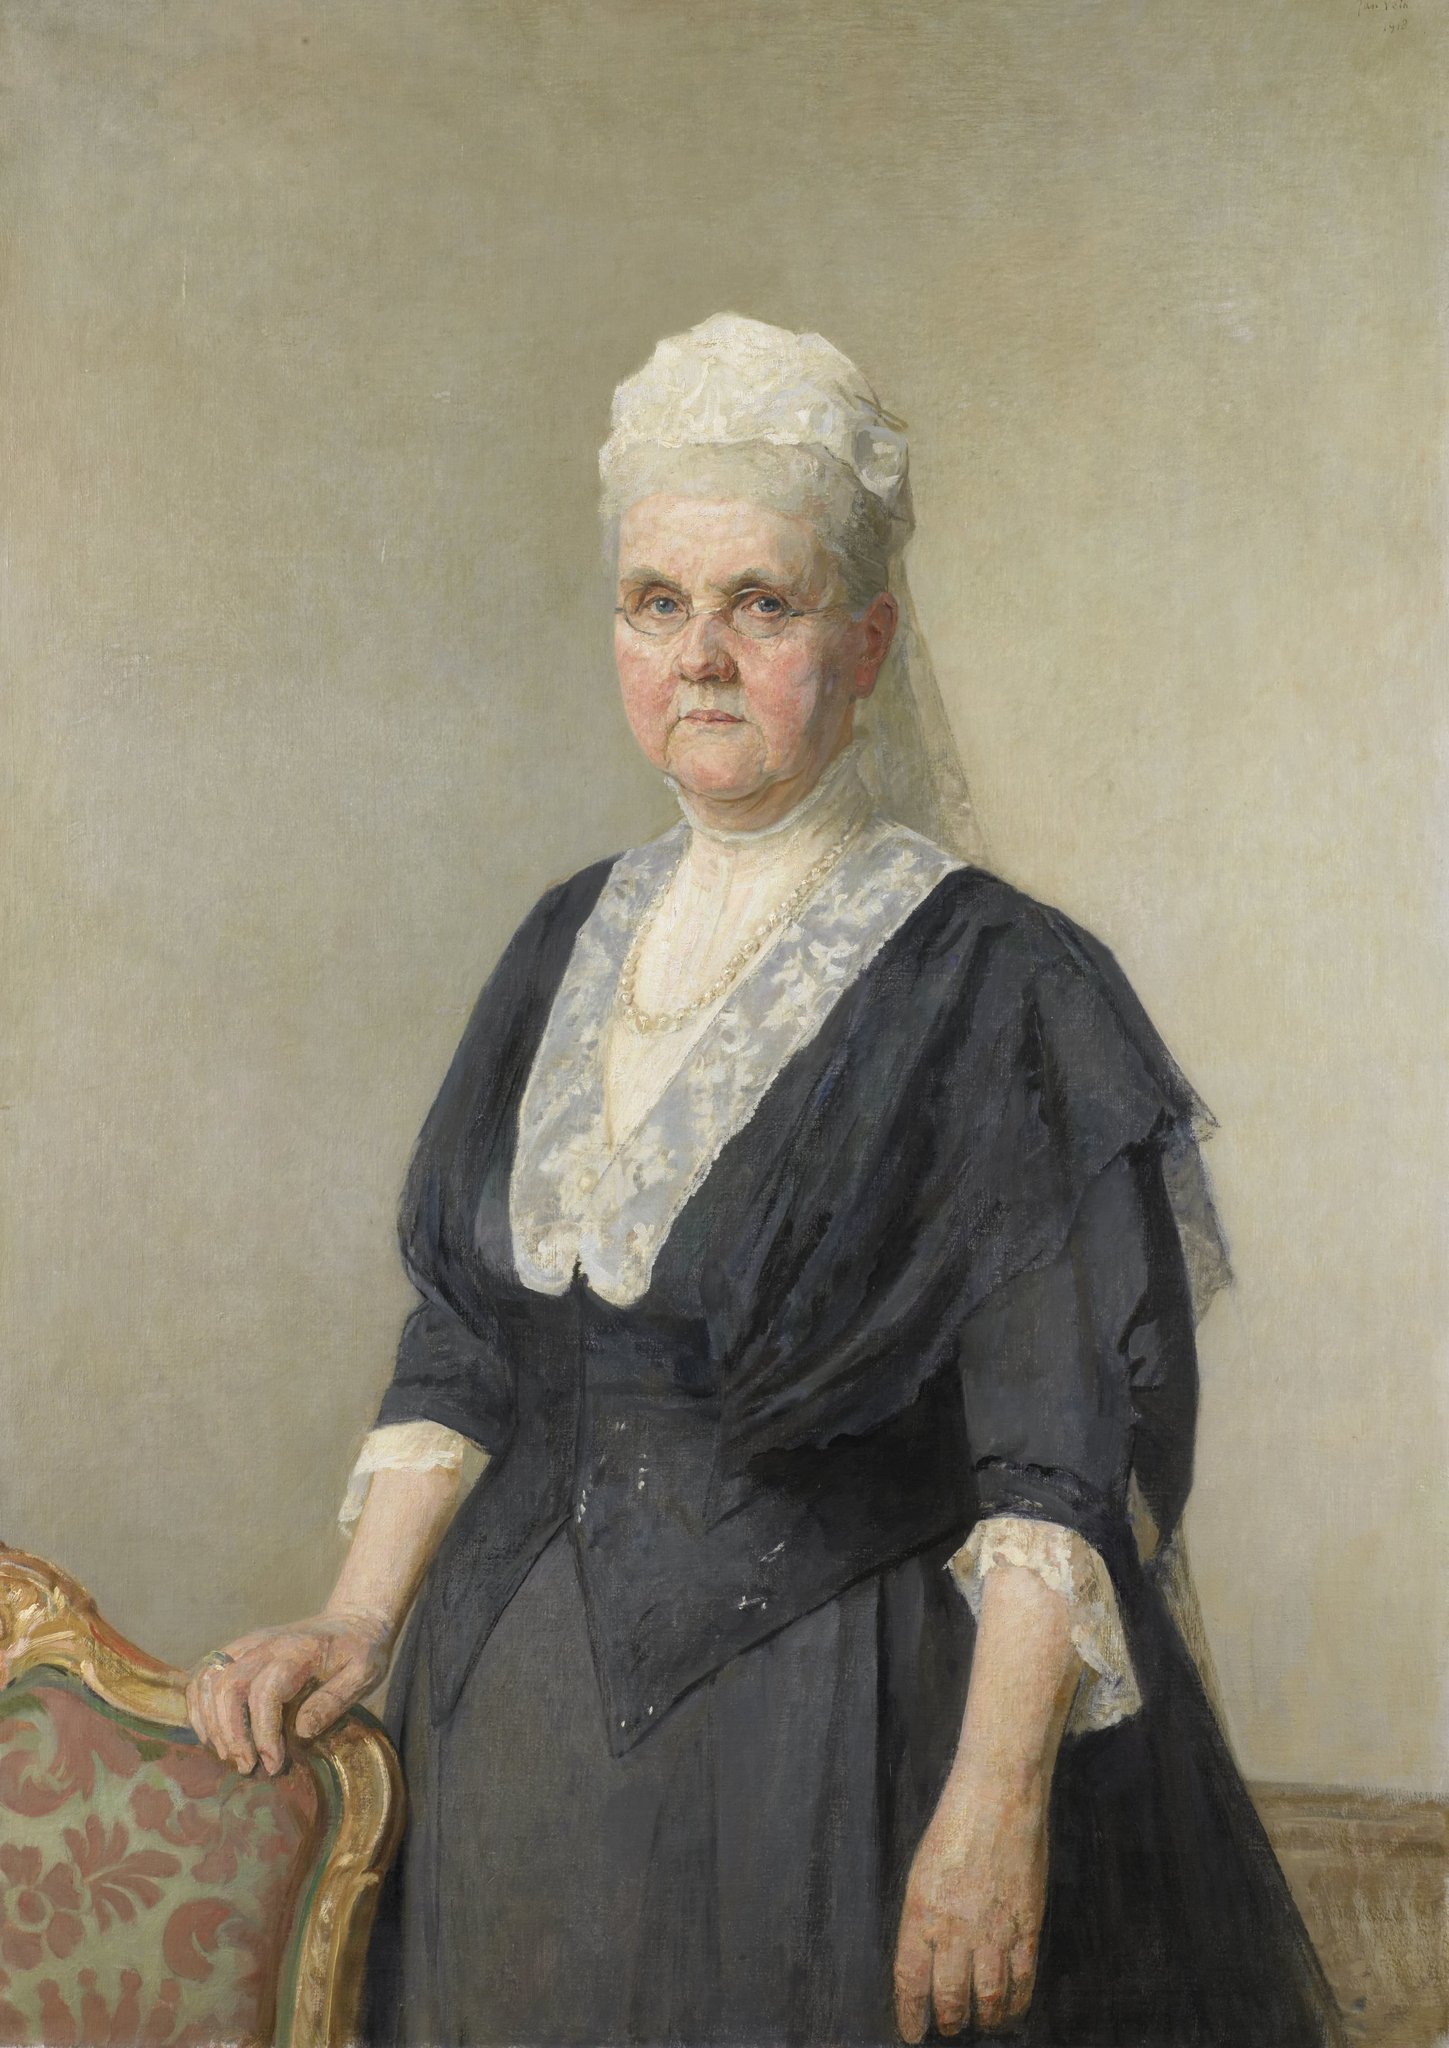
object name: painting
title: Koningin Emma, prinses van Waldeck-Pyrmont. Weduwe van koning Willem III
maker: jan veth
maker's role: designer, draughtsman, painter, print maker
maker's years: 1864-1925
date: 1918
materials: canvas, oil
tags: emma (queen consort of the netherlands), brussels, willem iii (koning der nederlanden), historical persons - bb - woman, queen, netherlands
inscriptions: signature and date: ‘Jan Veth 1918’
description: Portret van koningin Emma, prinses van Waldeck-Pyrmont, weduwe van koning Willem III. Heupstuk, staande met de rechterhand rustend op de rug van een stoel.